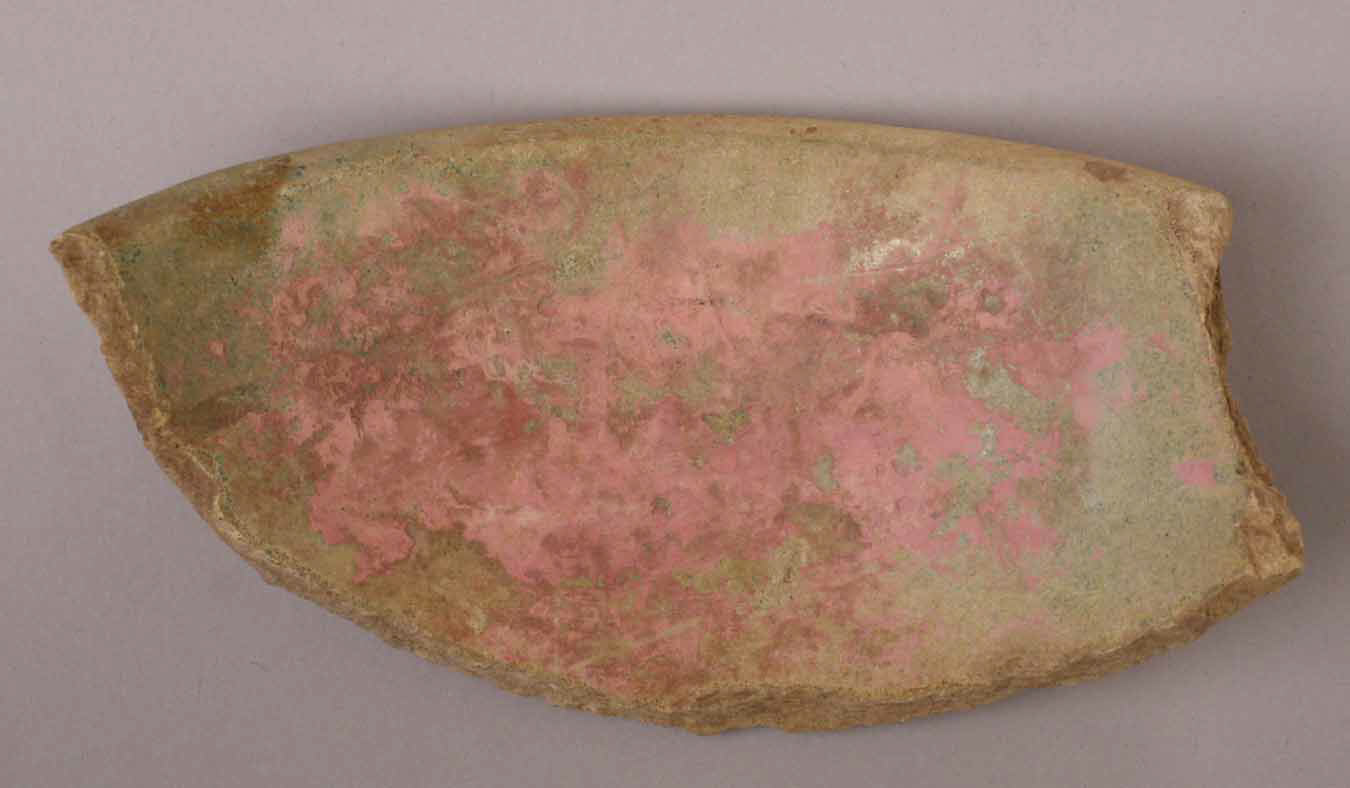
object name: fragment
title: Ceramic Fragment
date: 201-800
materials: earthenware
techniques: glazing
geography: iraq